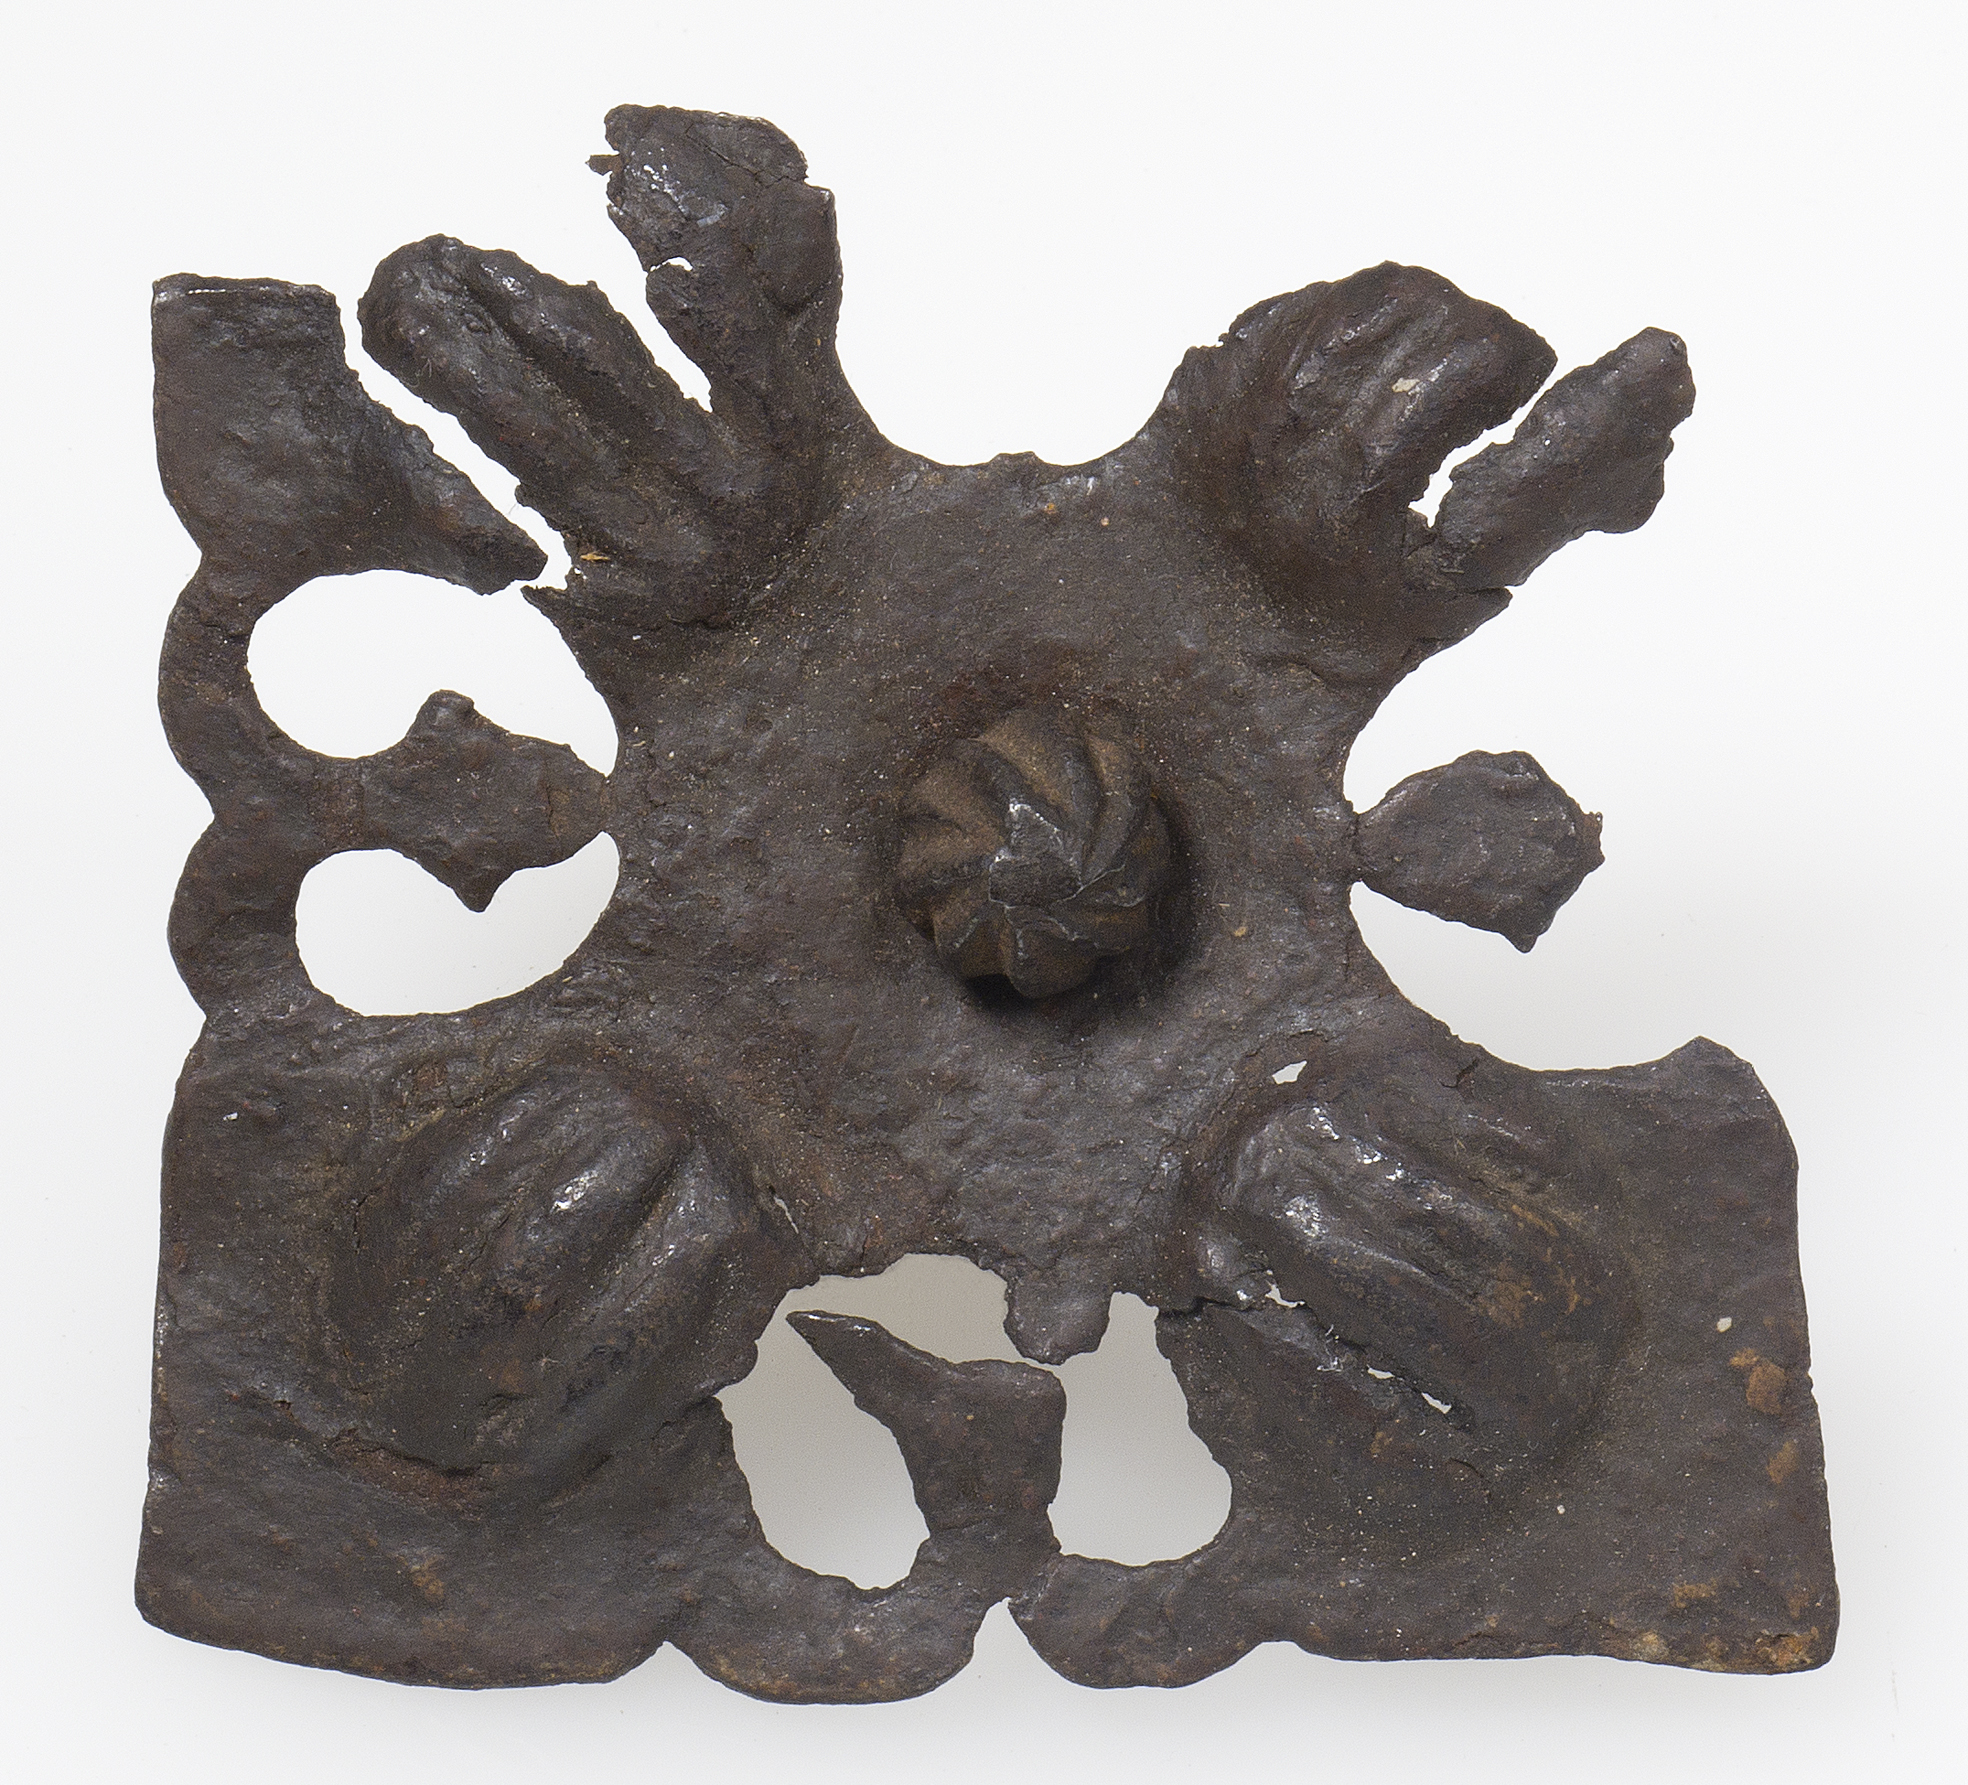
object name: plate and nail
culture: european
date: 1401-1600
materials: iron